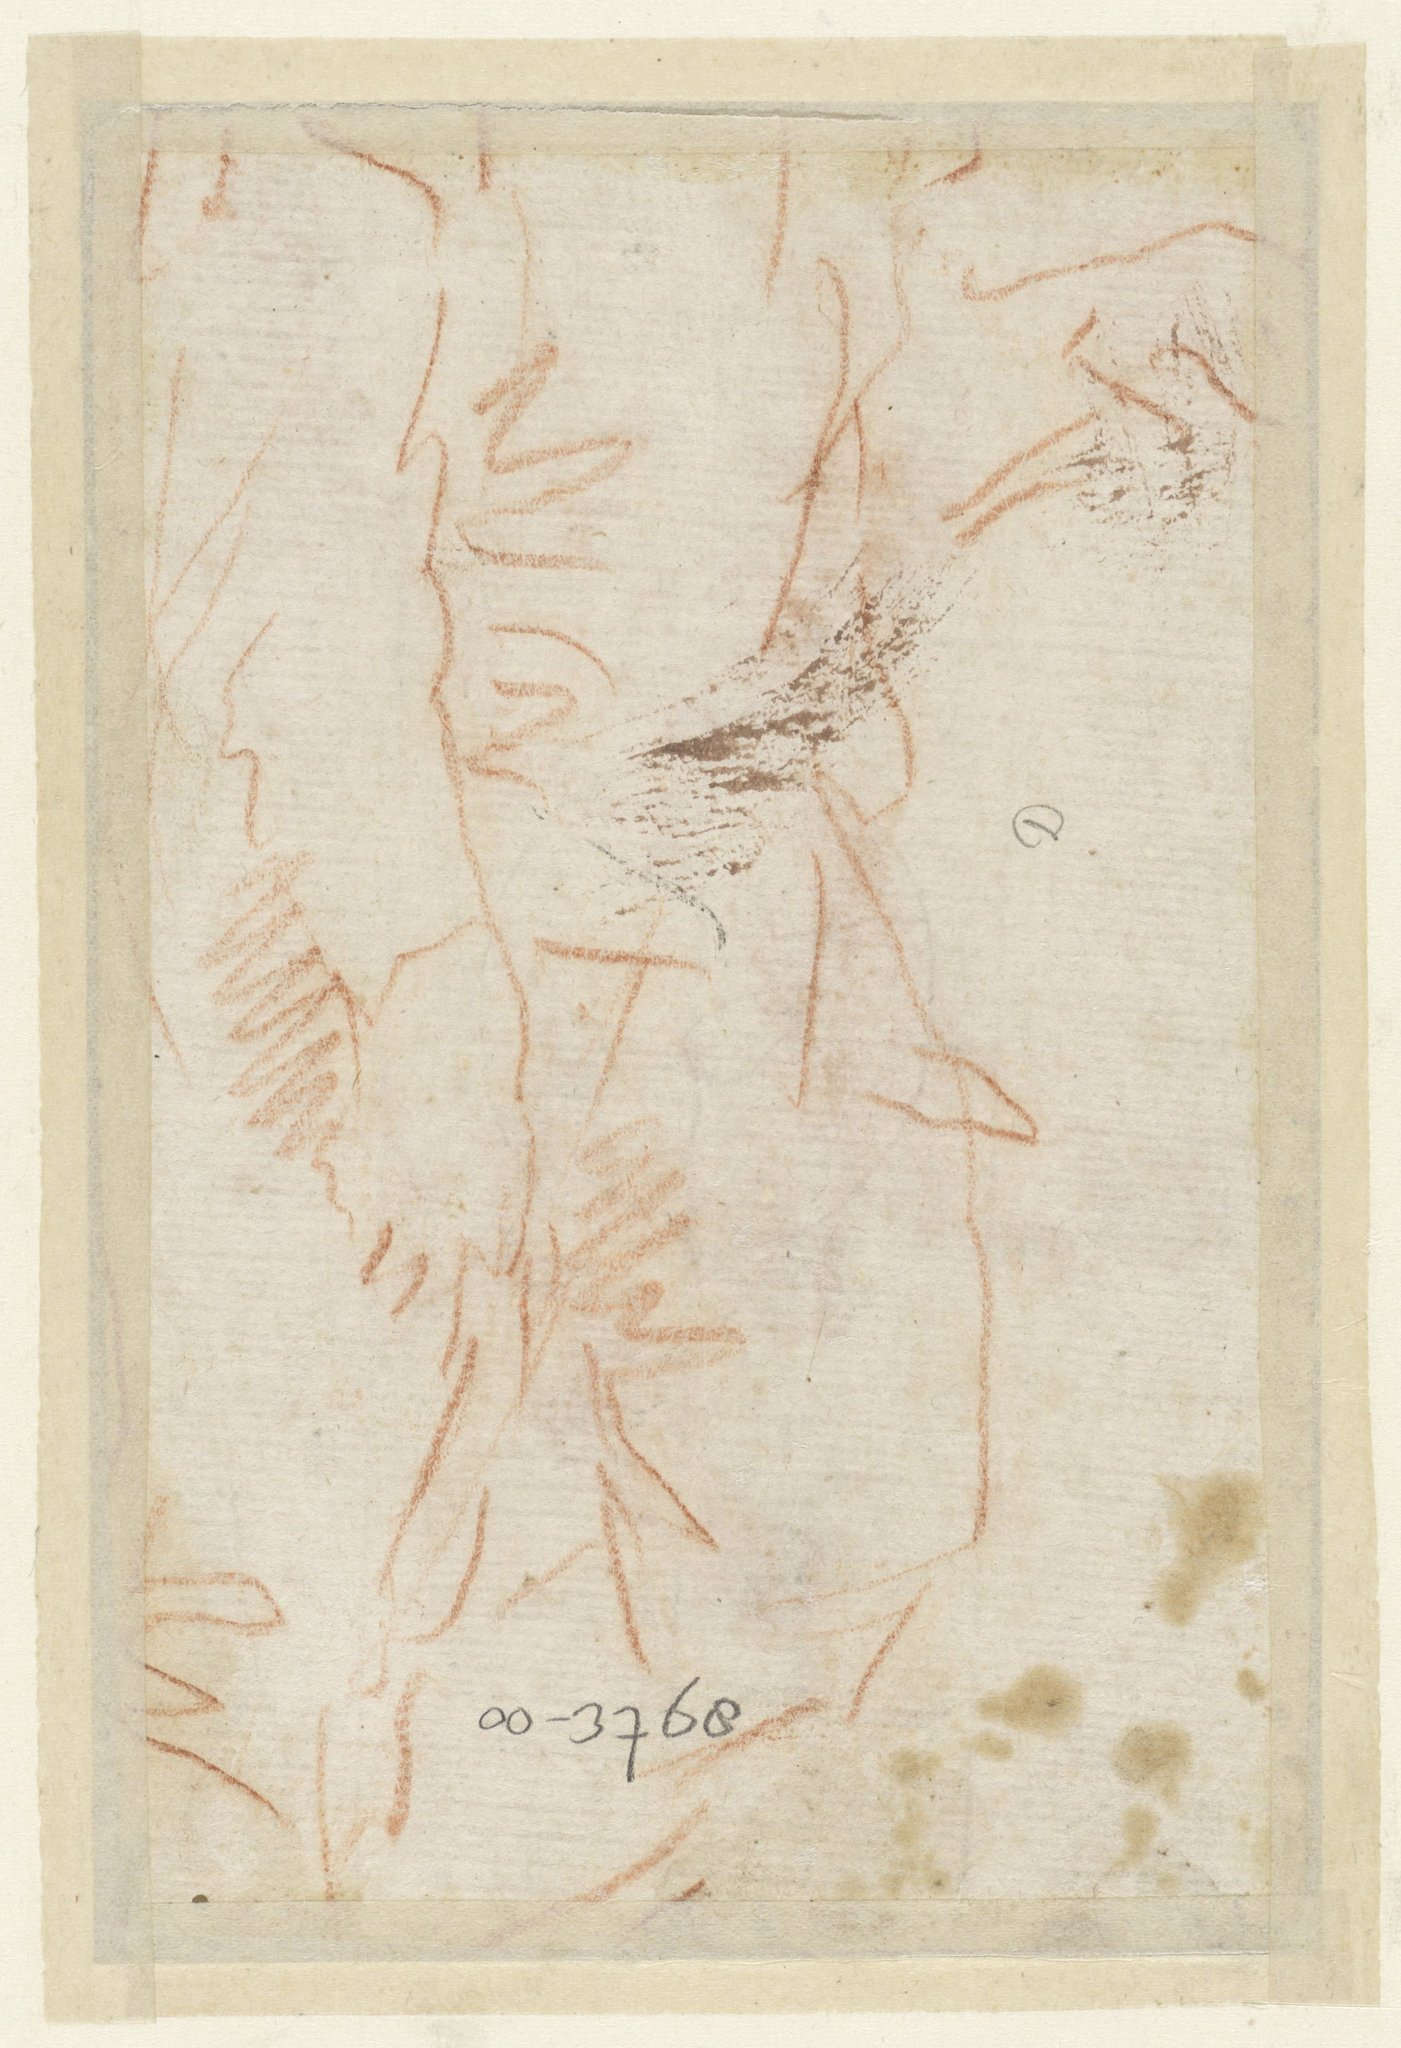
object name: drawing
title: Romp van een lopende man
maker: bartolomeo schedoni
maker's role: draughtsman, print maker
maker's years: 1578-1615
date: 1588-1615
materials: chalk, paper